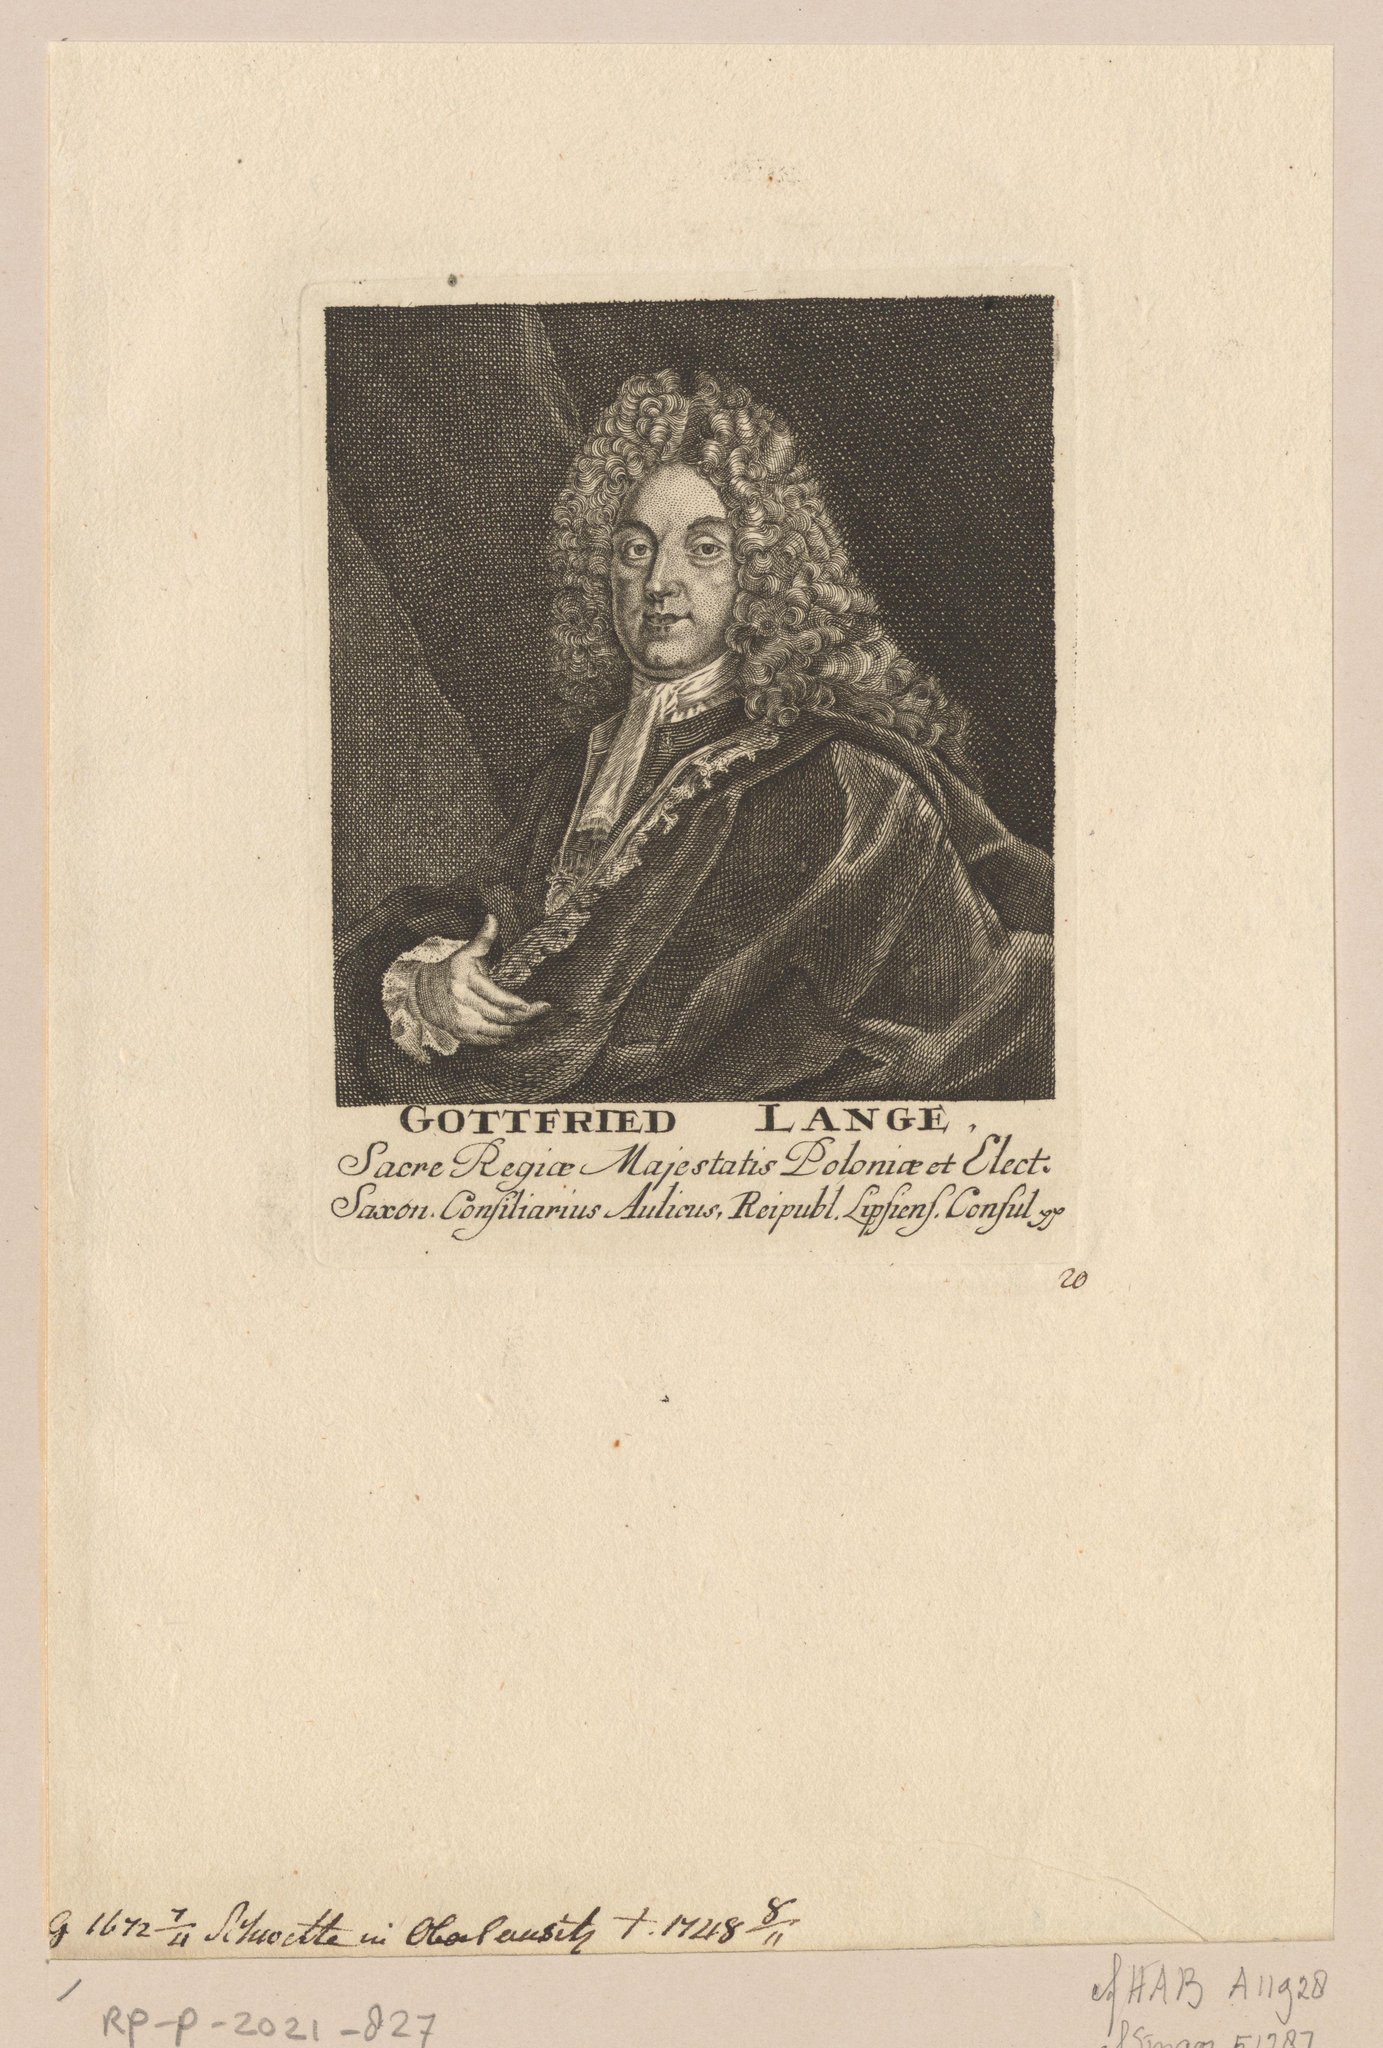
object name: print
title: Portret van Gottfried Lange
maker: Anonymous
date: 1725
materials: paper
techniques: engraving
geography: germany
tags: historical persons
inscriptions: inscription: ‘G 1672 7/4 Schwerta in [...] + 1748 8/11’, number: ‘20’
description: Prent mogelijk uit: Roth-Scholtz, Friedrich. Icones virorum omnium ordinum eruditione omnique item genere (...). Neurenberg: erven Johann Daniel Tauber, 1725.